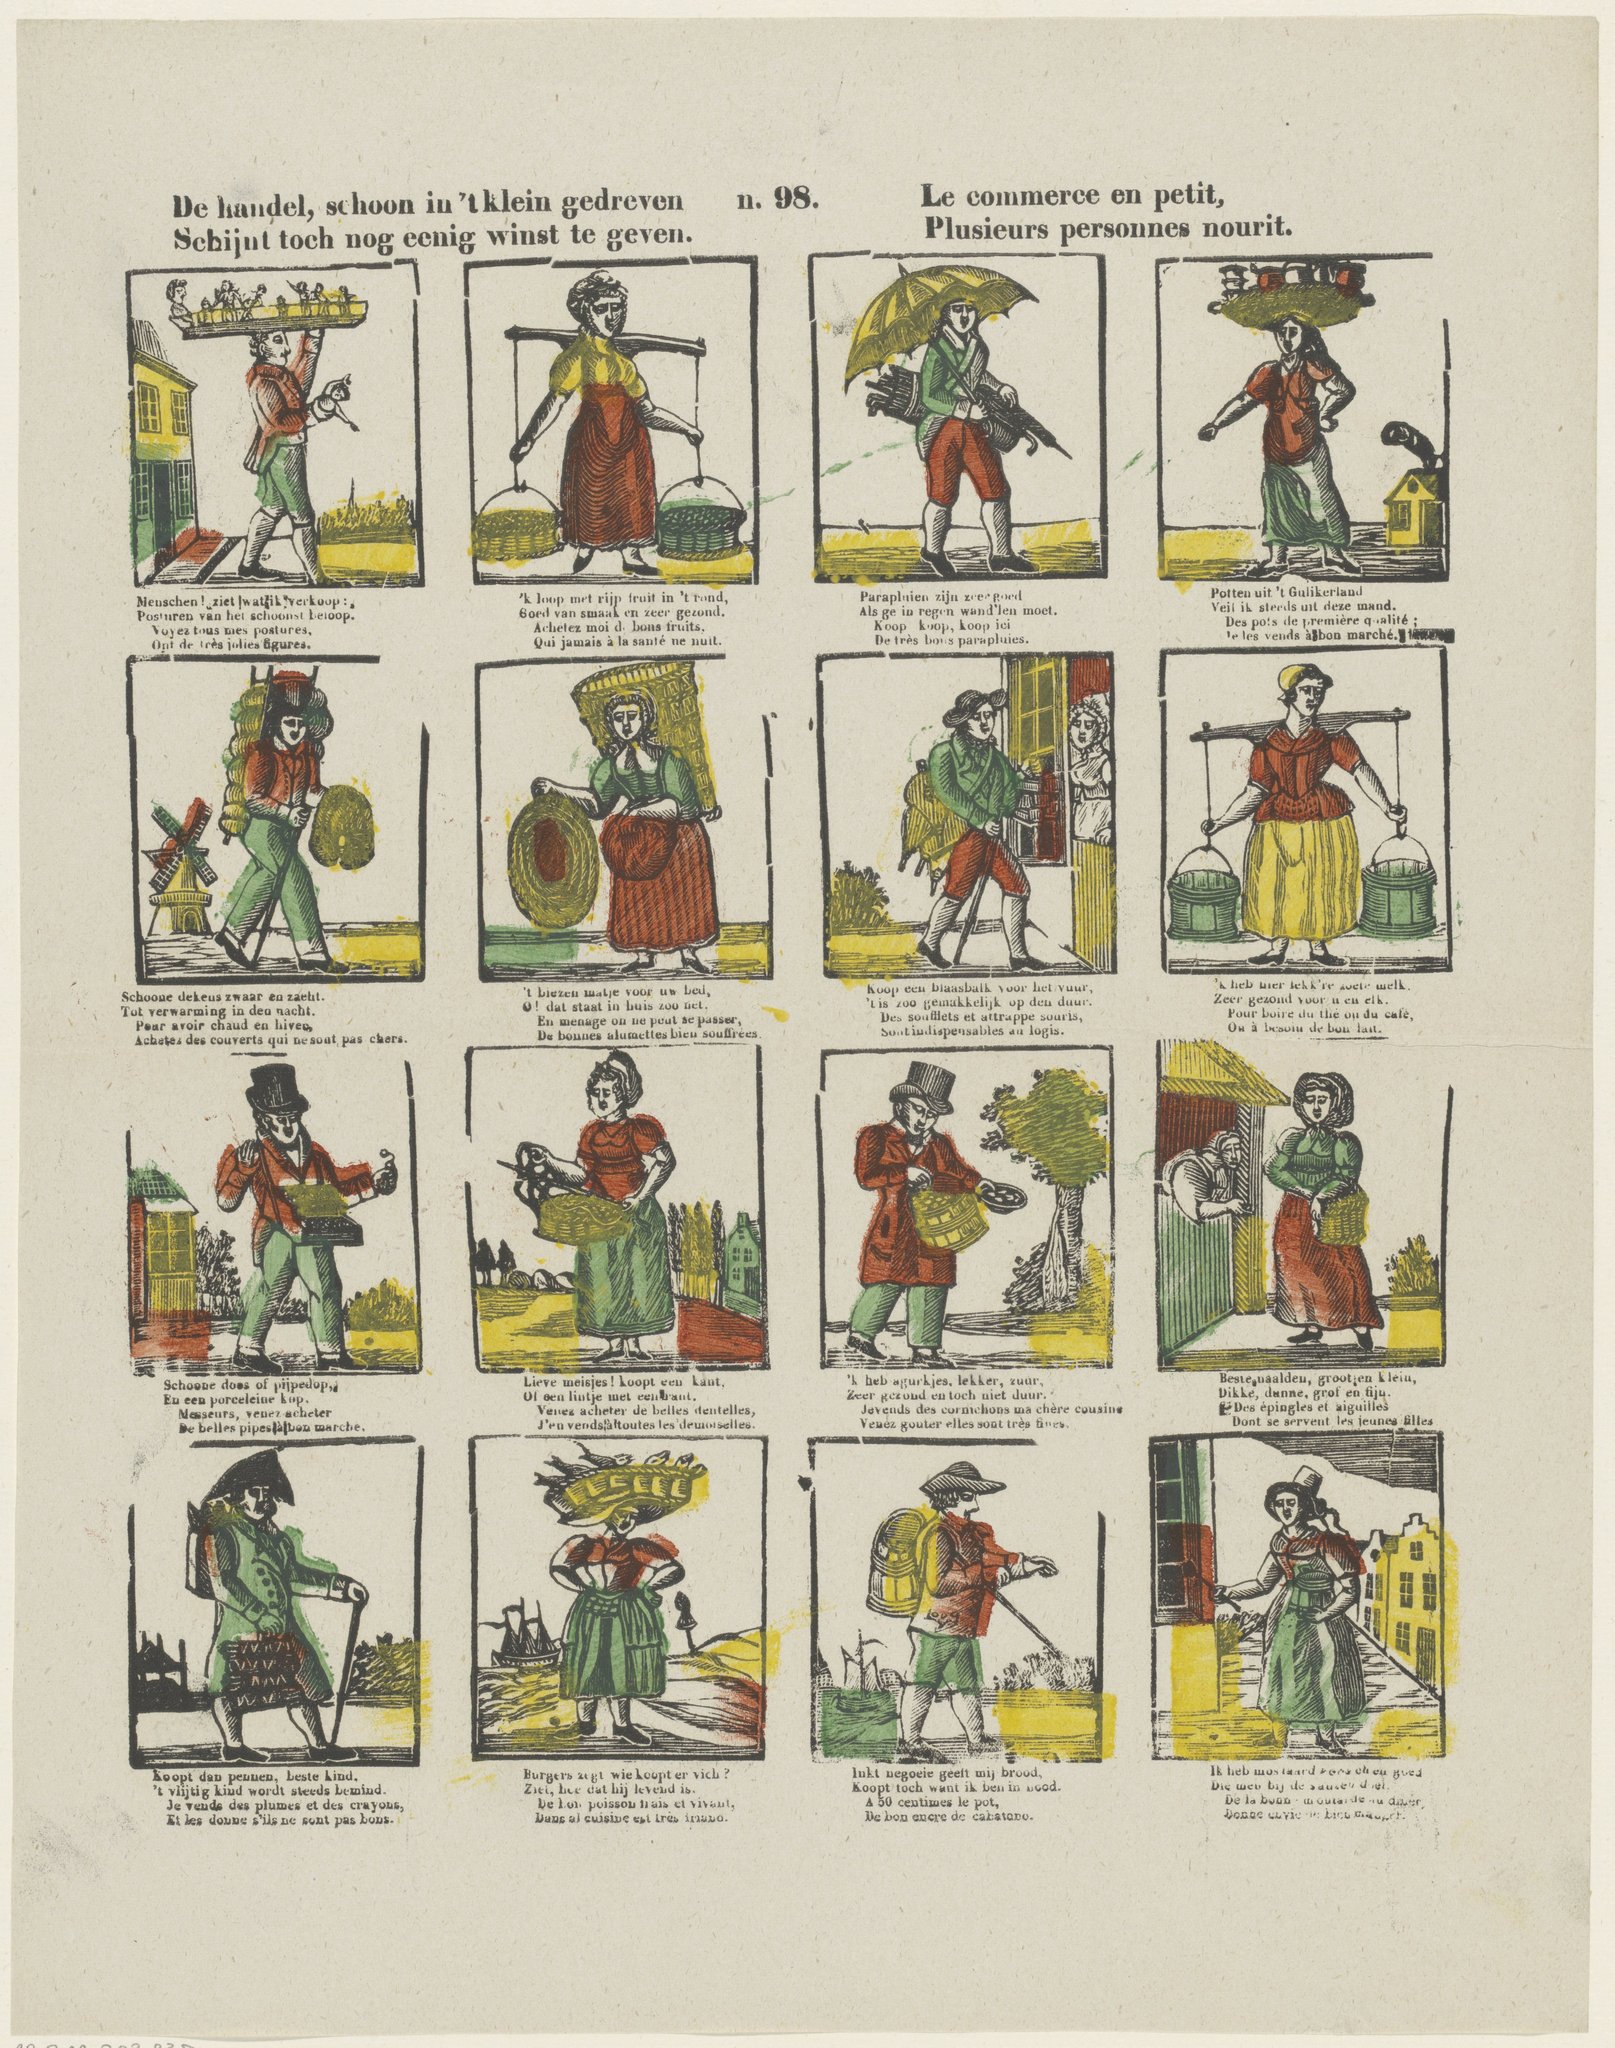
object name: print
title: De handel, schoon in 't klein gedreven / Schijnt toch nog eenig winst te geven / Le commerce en petit, / Plusiers personnes nourit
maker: Anonymous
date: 1856-1900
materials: paper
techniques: colour, letterpress printing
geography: turnhout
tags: street-trader, merchant, salesman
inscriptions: collector's mark: Lugt 2760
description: Blad met 16 voorstellingen van verkopers, zoals een dekenverkoper, een augurkenverkoper en een visverkoopster. Onder elke afbeelding een tweeregelig vers in het Nederlands en in het Frans. Genummerd midden boven: n. 98.